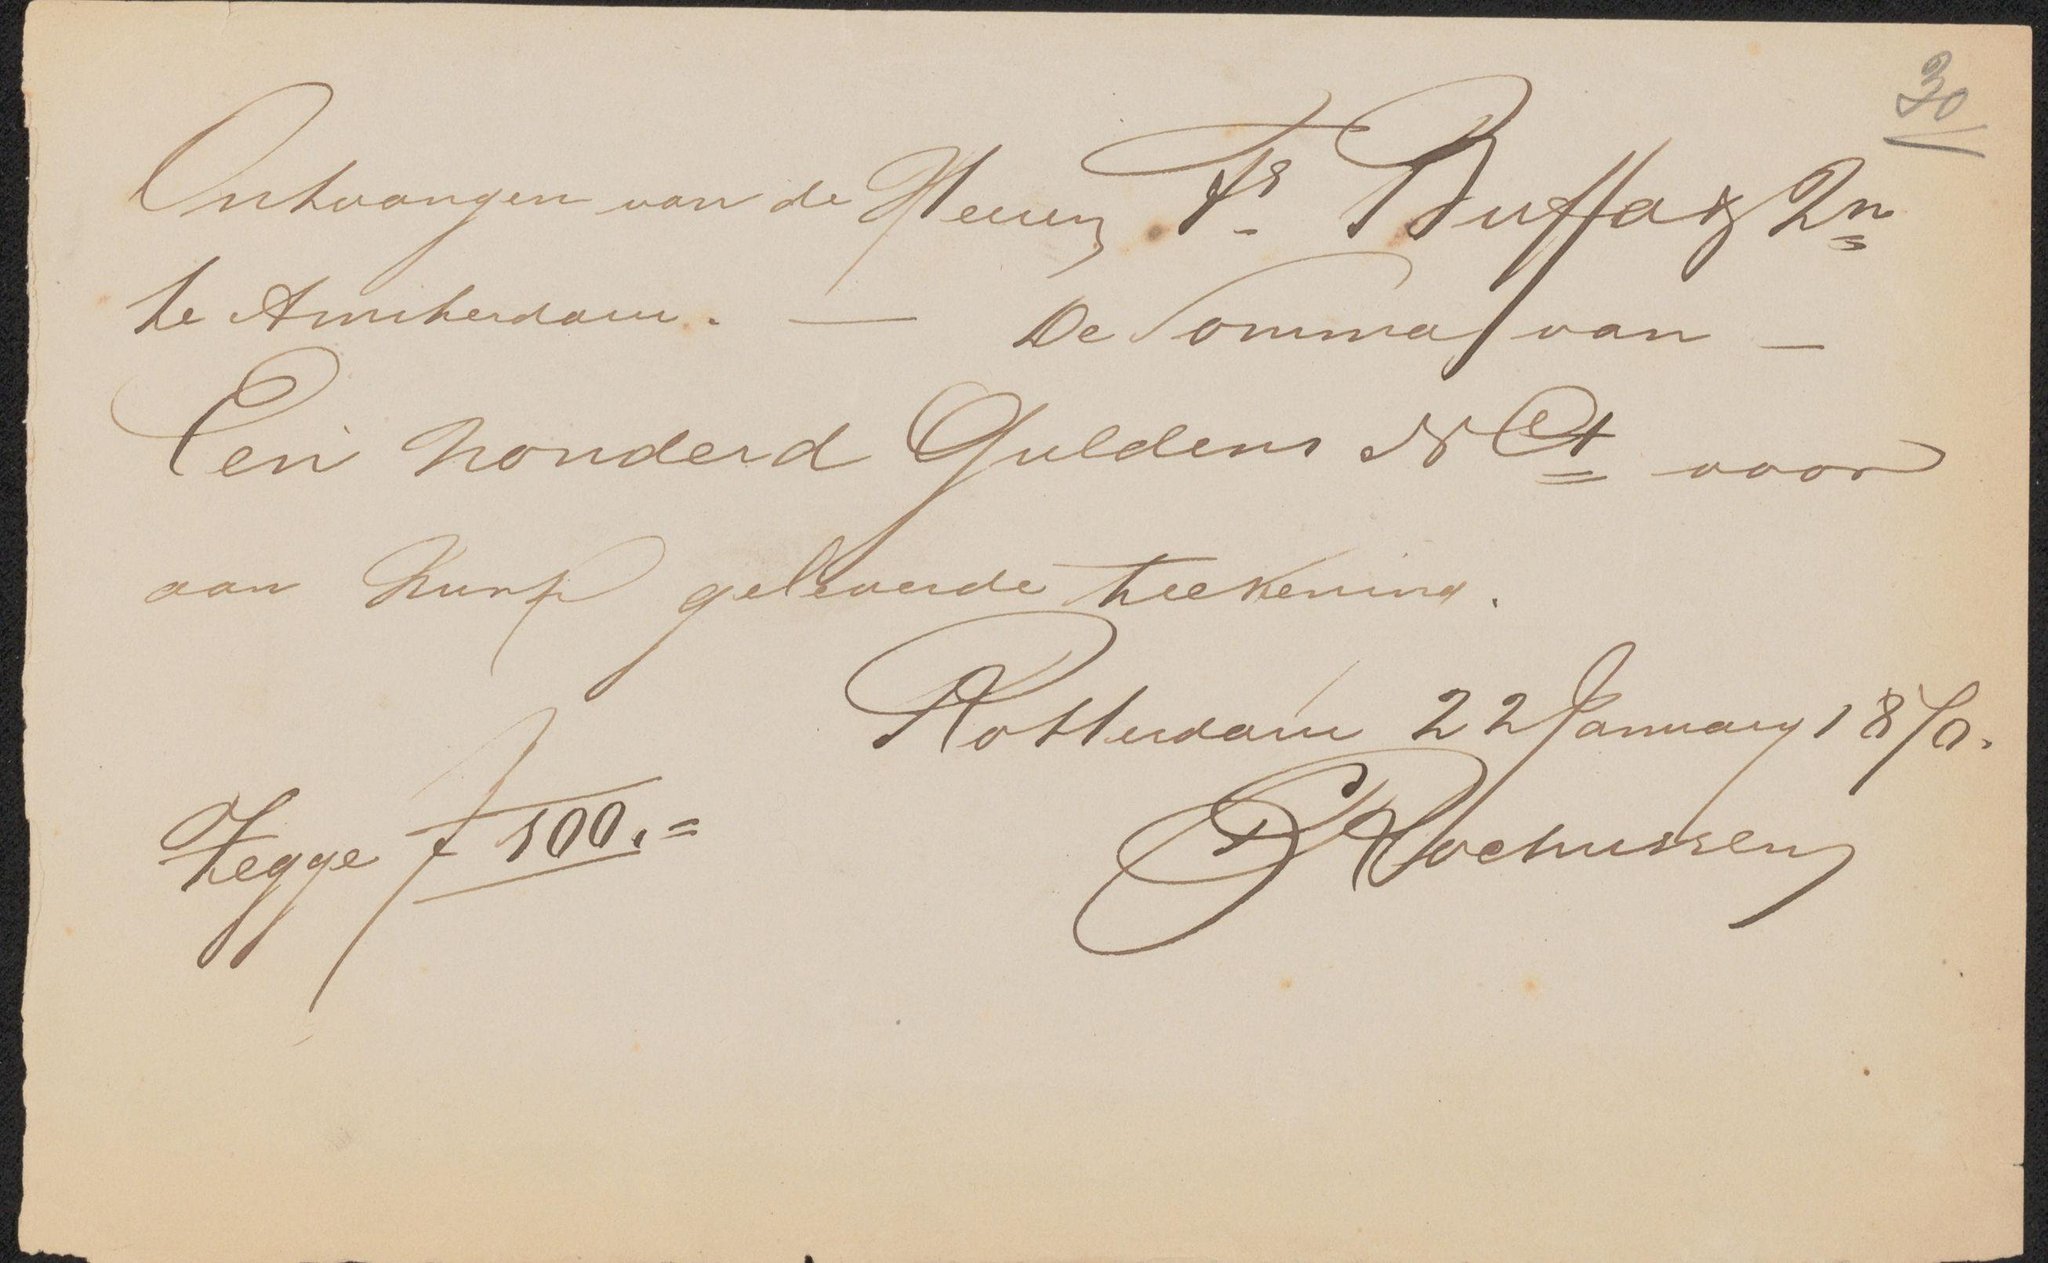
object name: ontvangstbewijs, kwitantie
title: Kwitantie voor Charles Rochussen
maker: charles rochussen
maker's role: draughtsman, painter, print maker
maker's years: 1814-1894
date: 1870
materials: ink, paper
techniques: pen, writing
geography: rotterdam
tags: publisher, drawing, money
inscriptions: collector's mark: Lugt 2233